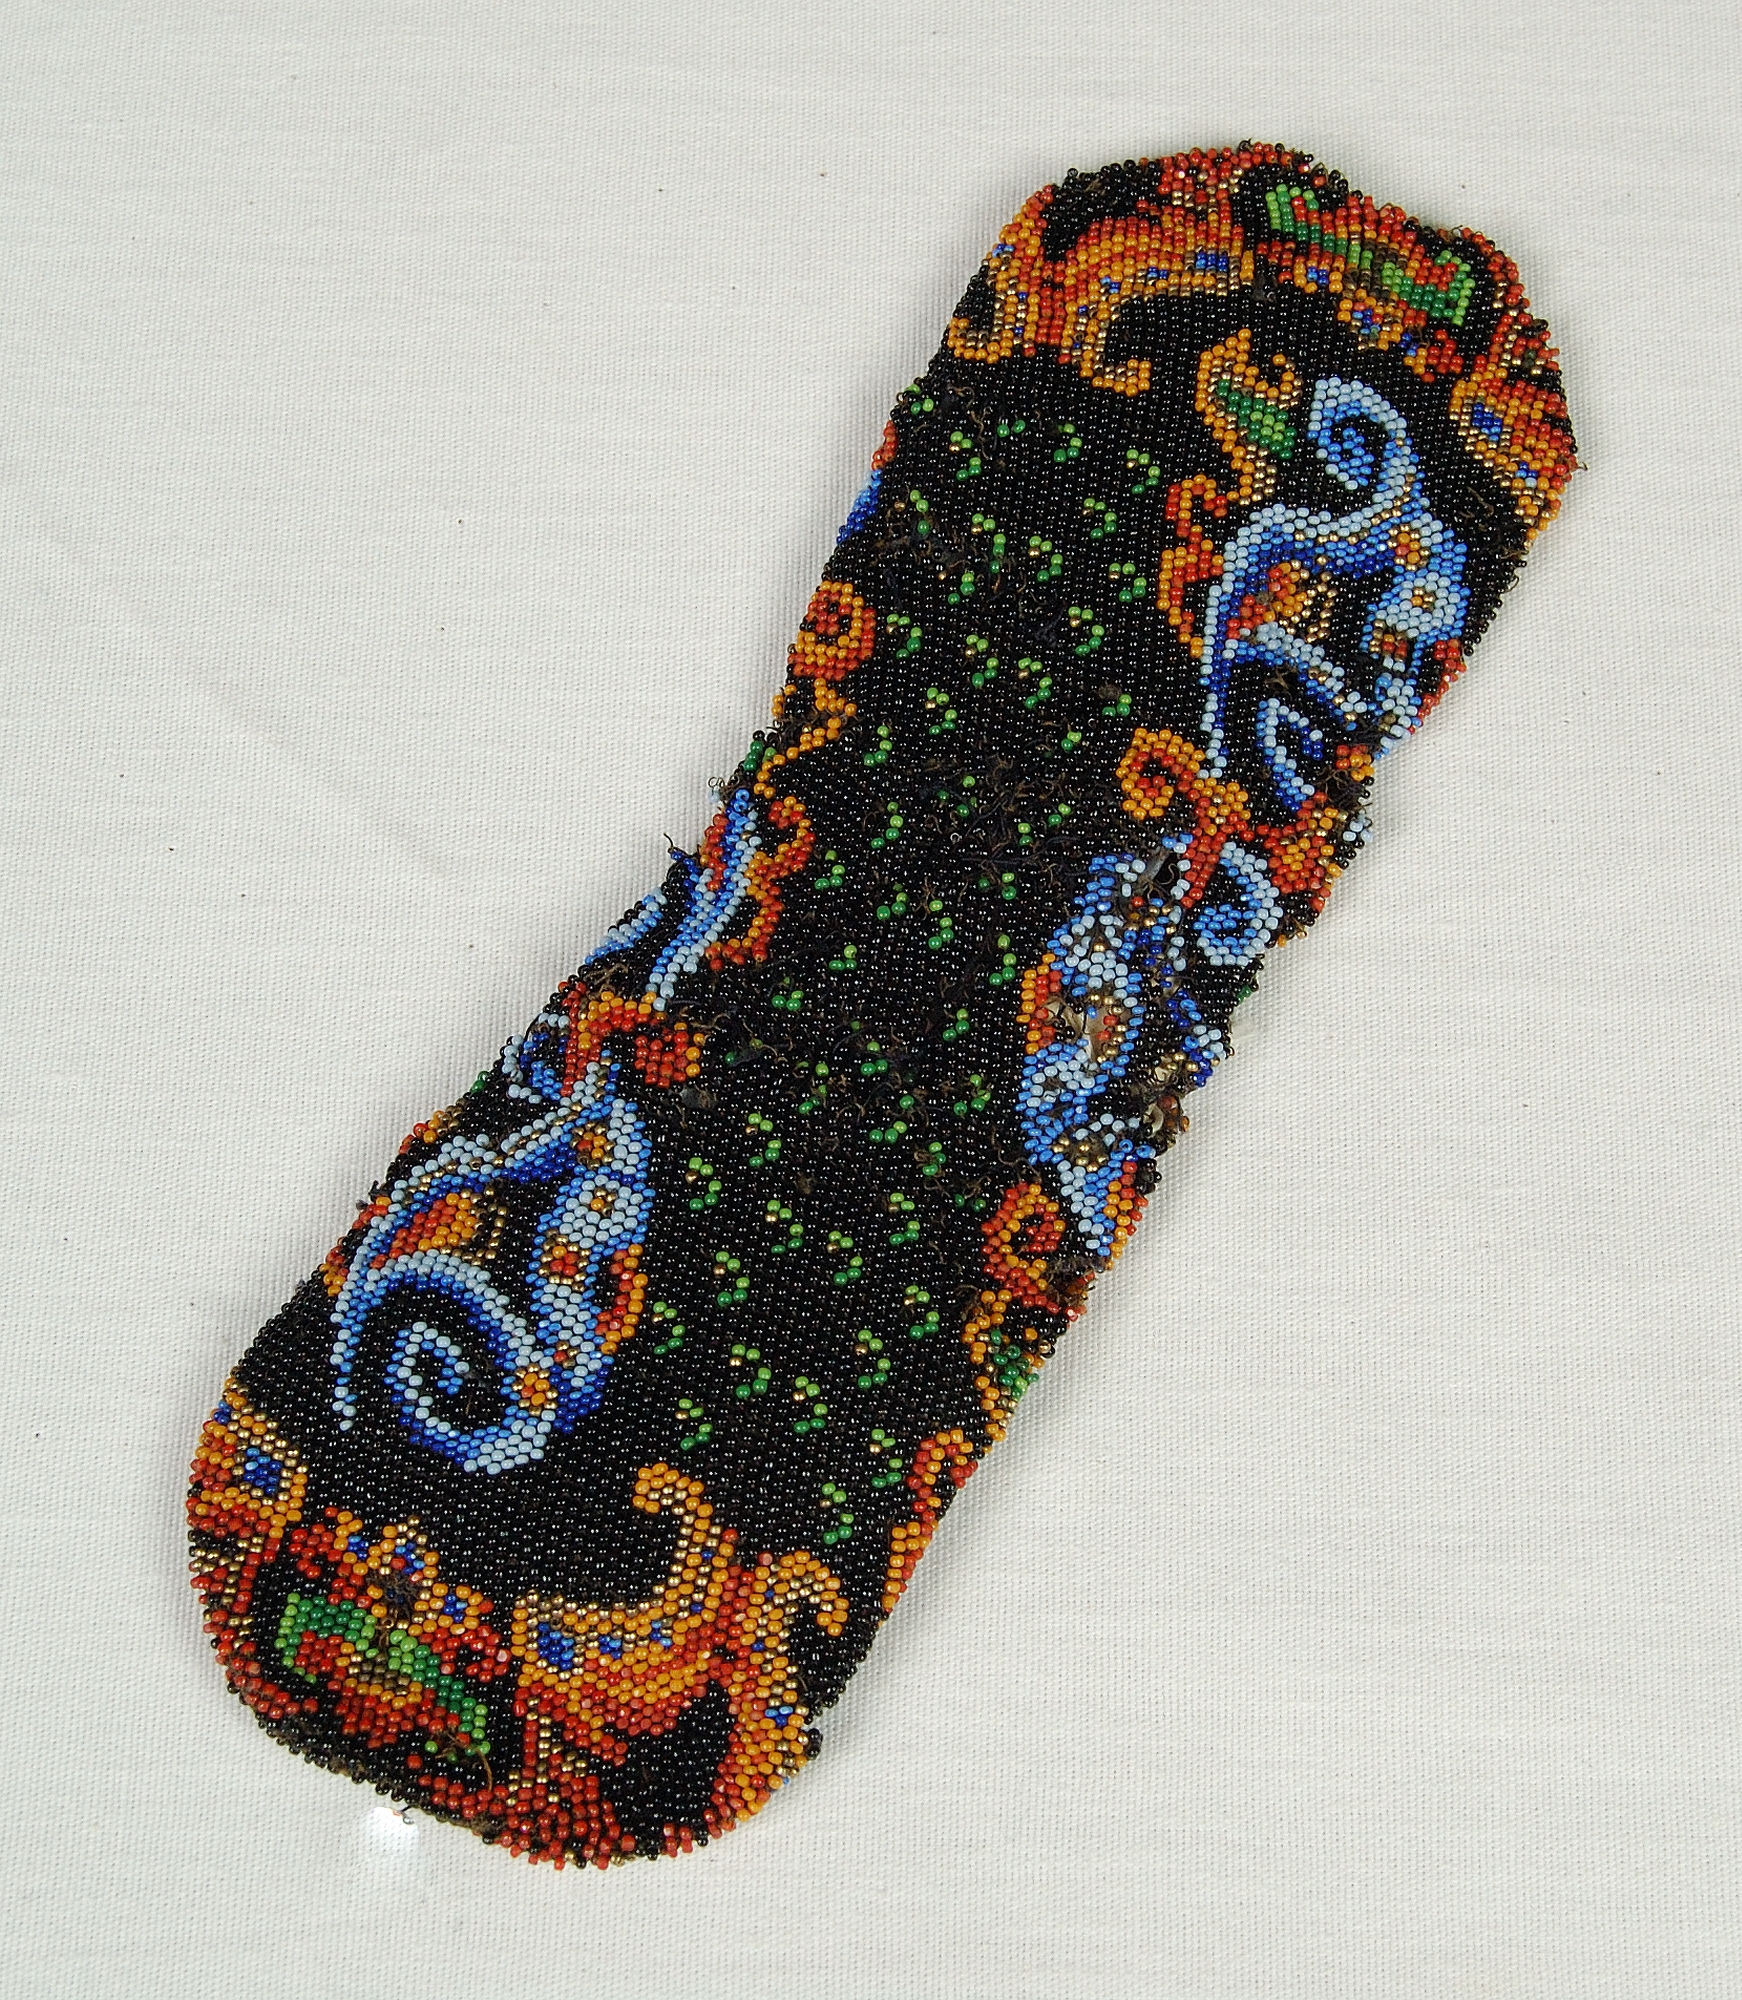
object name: miser's purse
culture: mexican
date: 1840-1860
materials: glass, linen